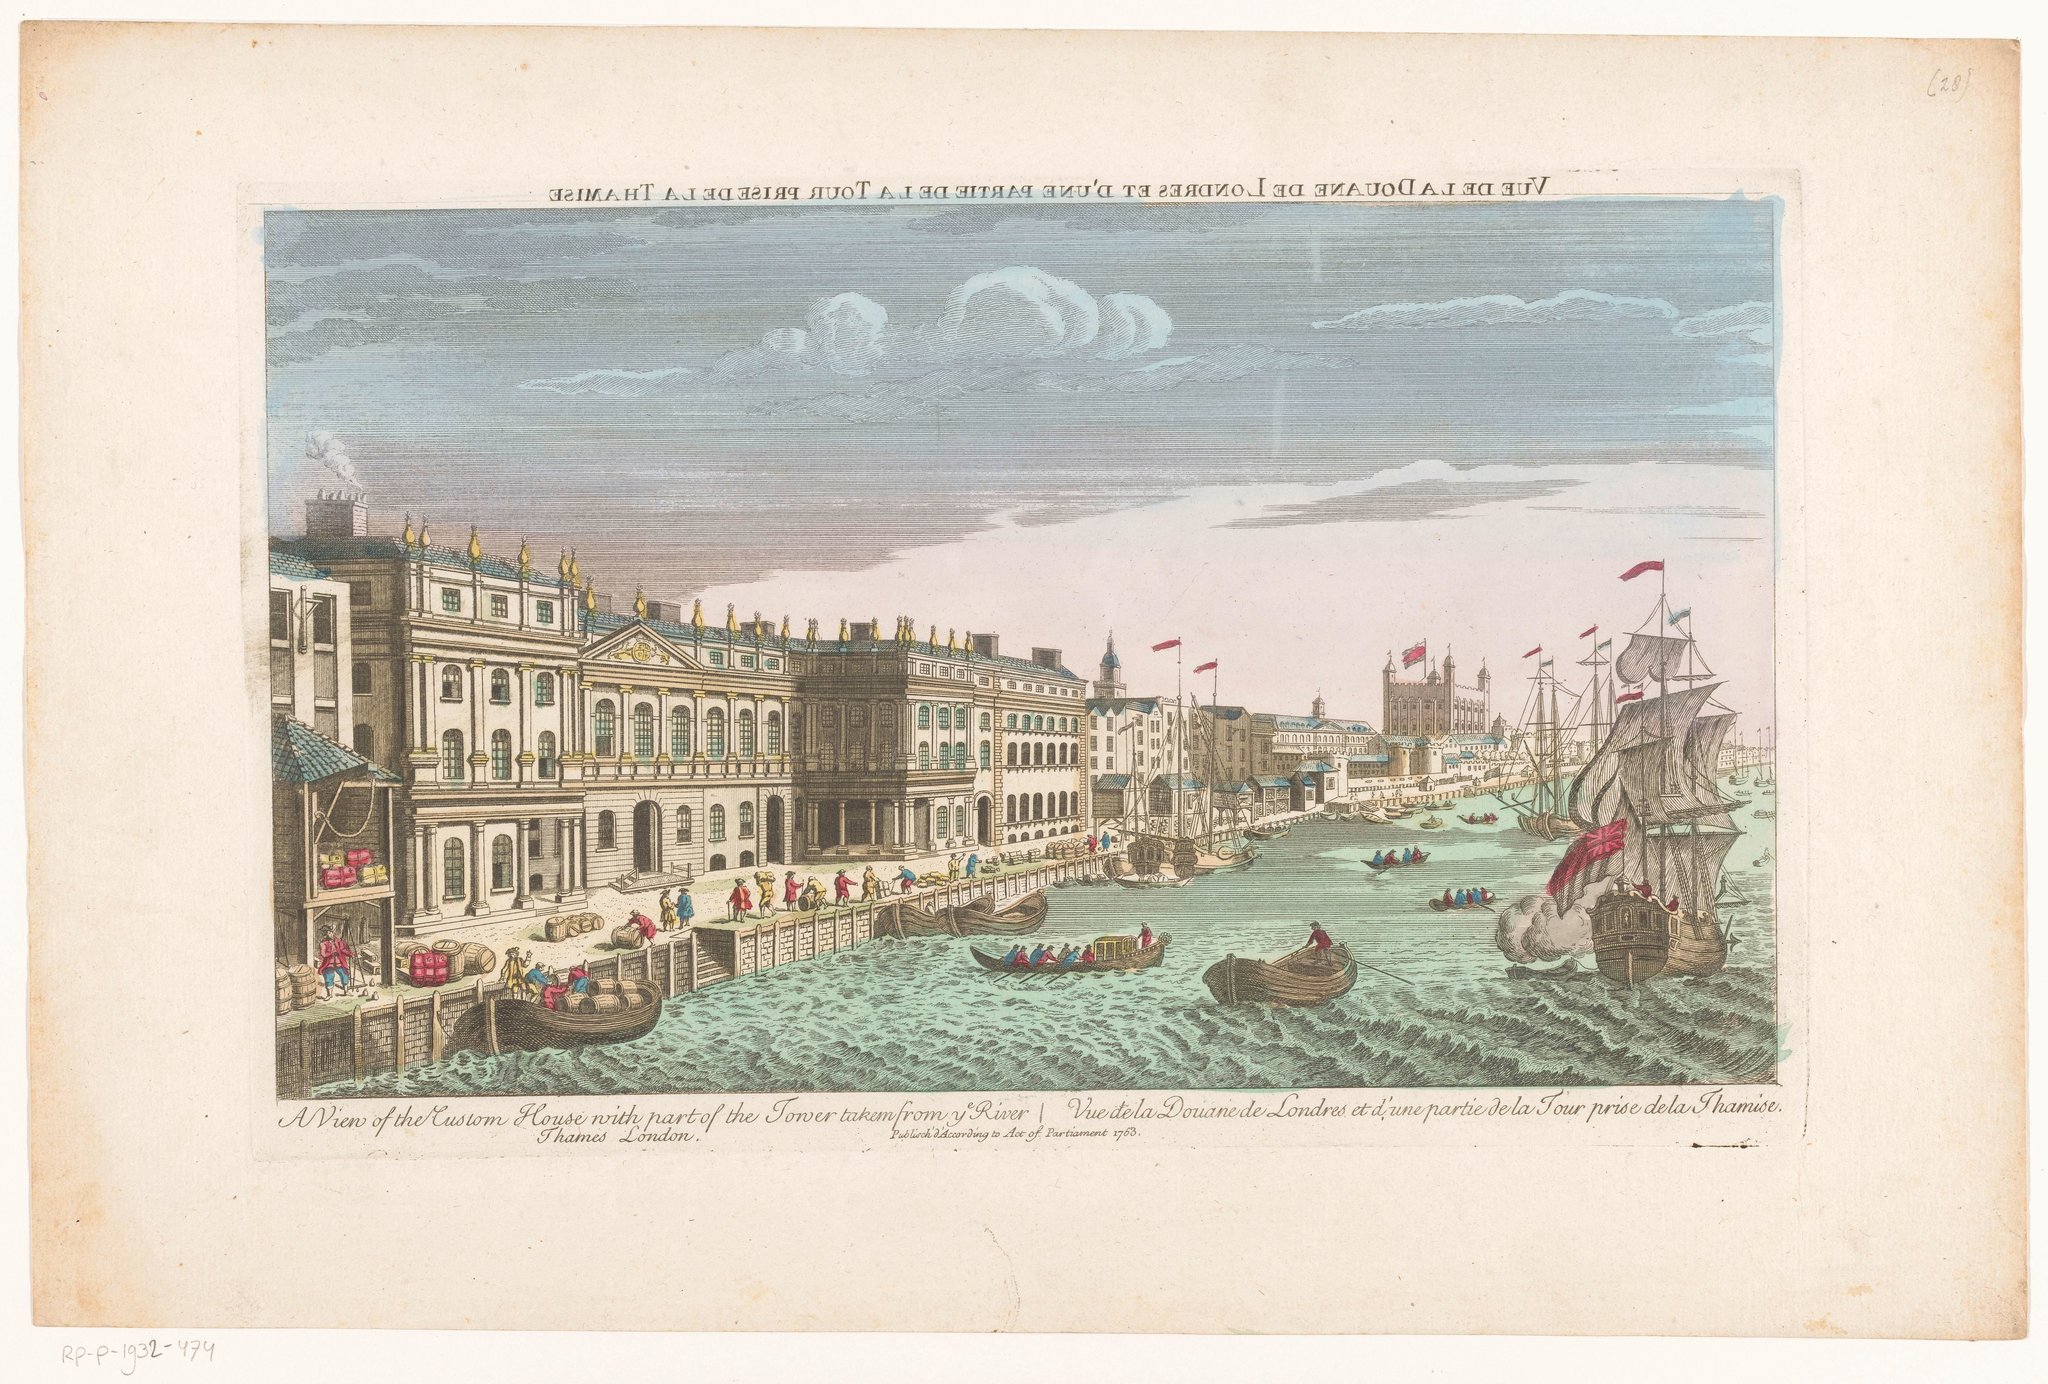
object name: opticaprent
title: Gezicht op het Custom House aan de rivier de Theems te Londen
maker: Anonymous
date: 1753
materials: paper, watercolor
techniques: brush, etching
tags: customs, canals, waters (in city) (+ city(-scape) with figures, staffage), thames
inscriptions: watermark